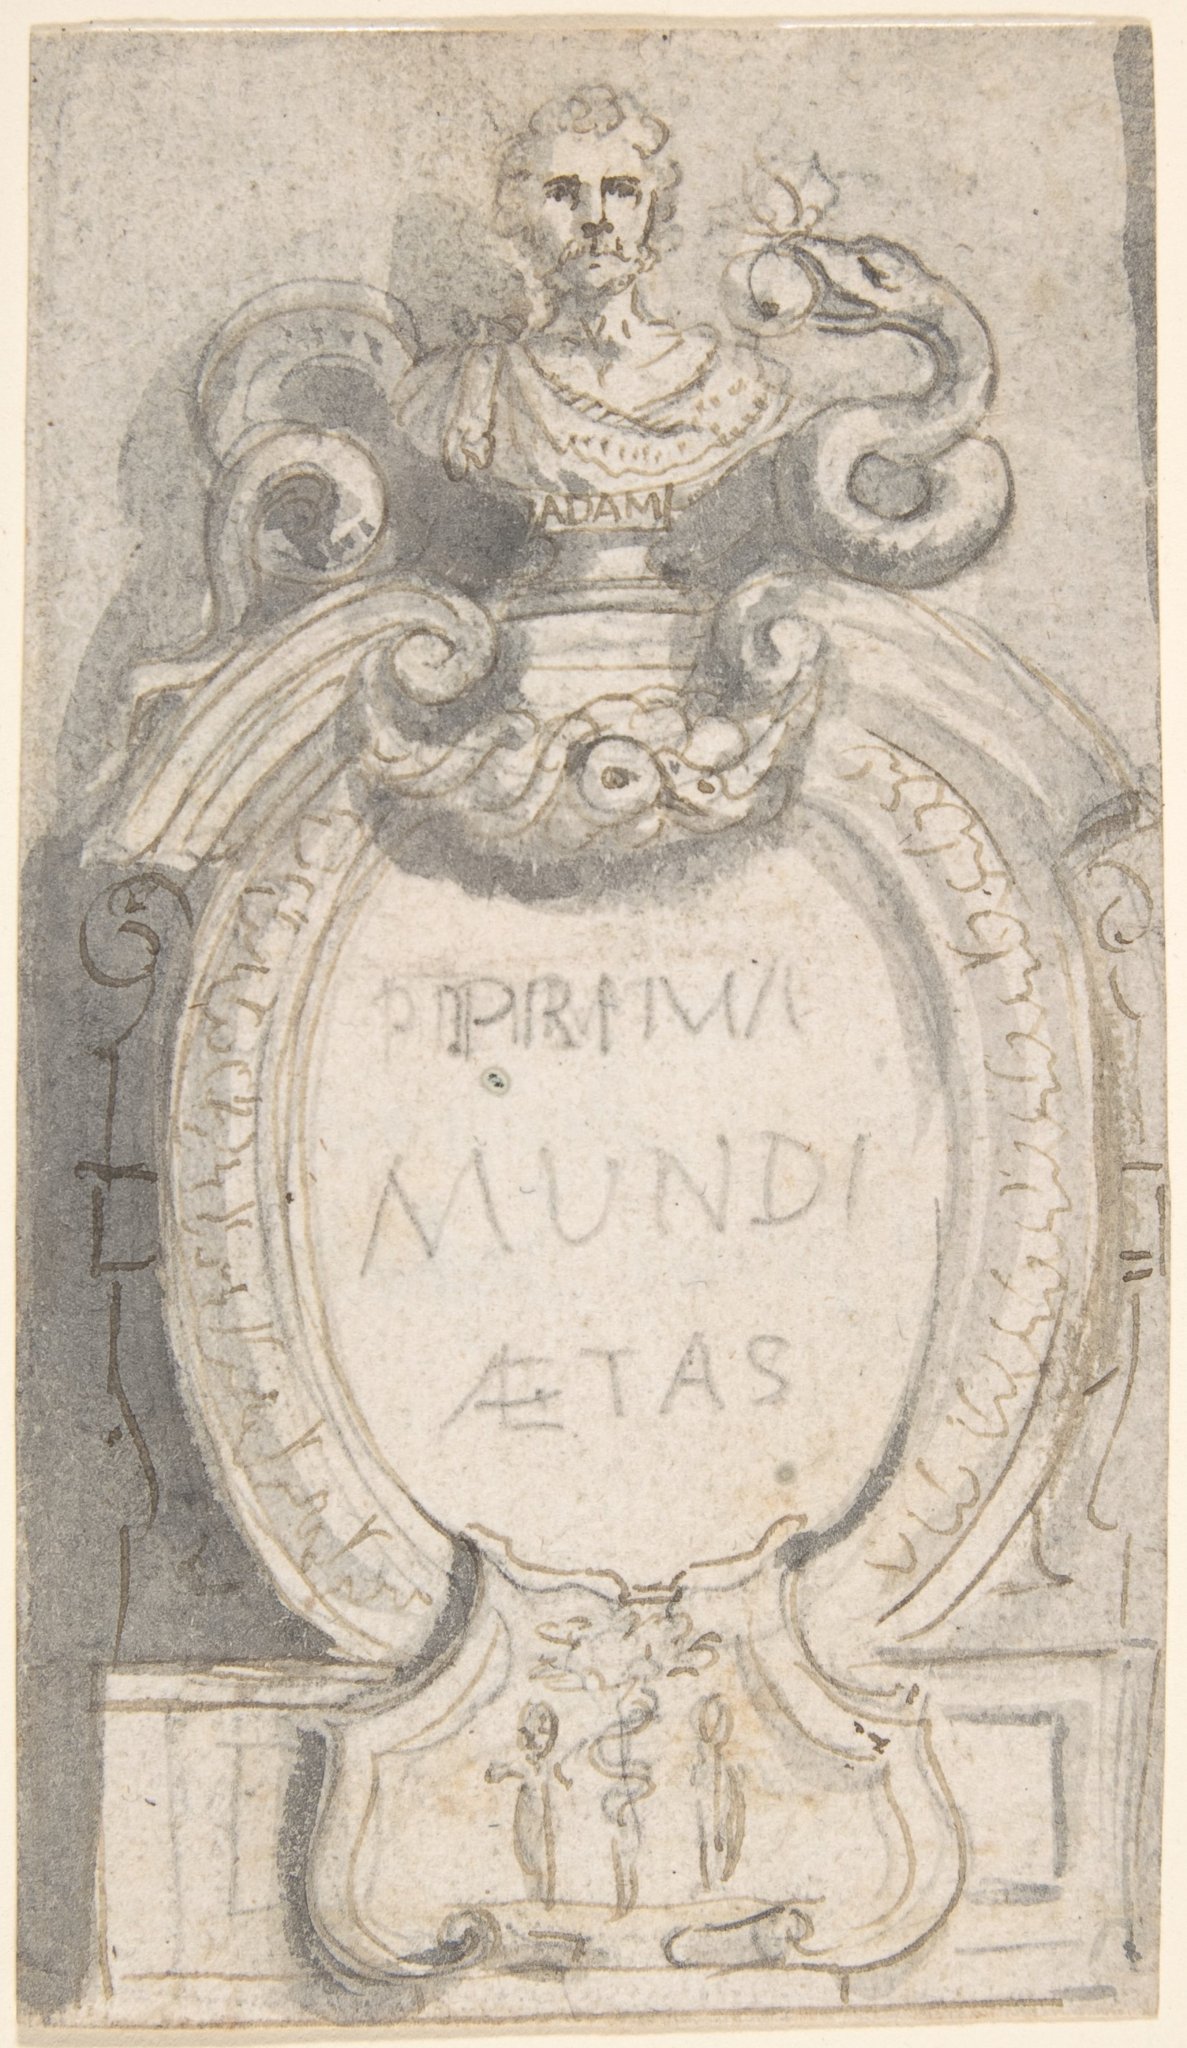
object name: drawing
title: Cartouche Surmounted by a Bust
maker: anonymous, italian, 18th century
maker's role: artist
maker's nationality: italian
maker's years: 1700-1800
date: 1701-1800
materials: chalk, graphite, ink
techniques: brush, pen, wash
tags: cartouches,men,portraits,snakes